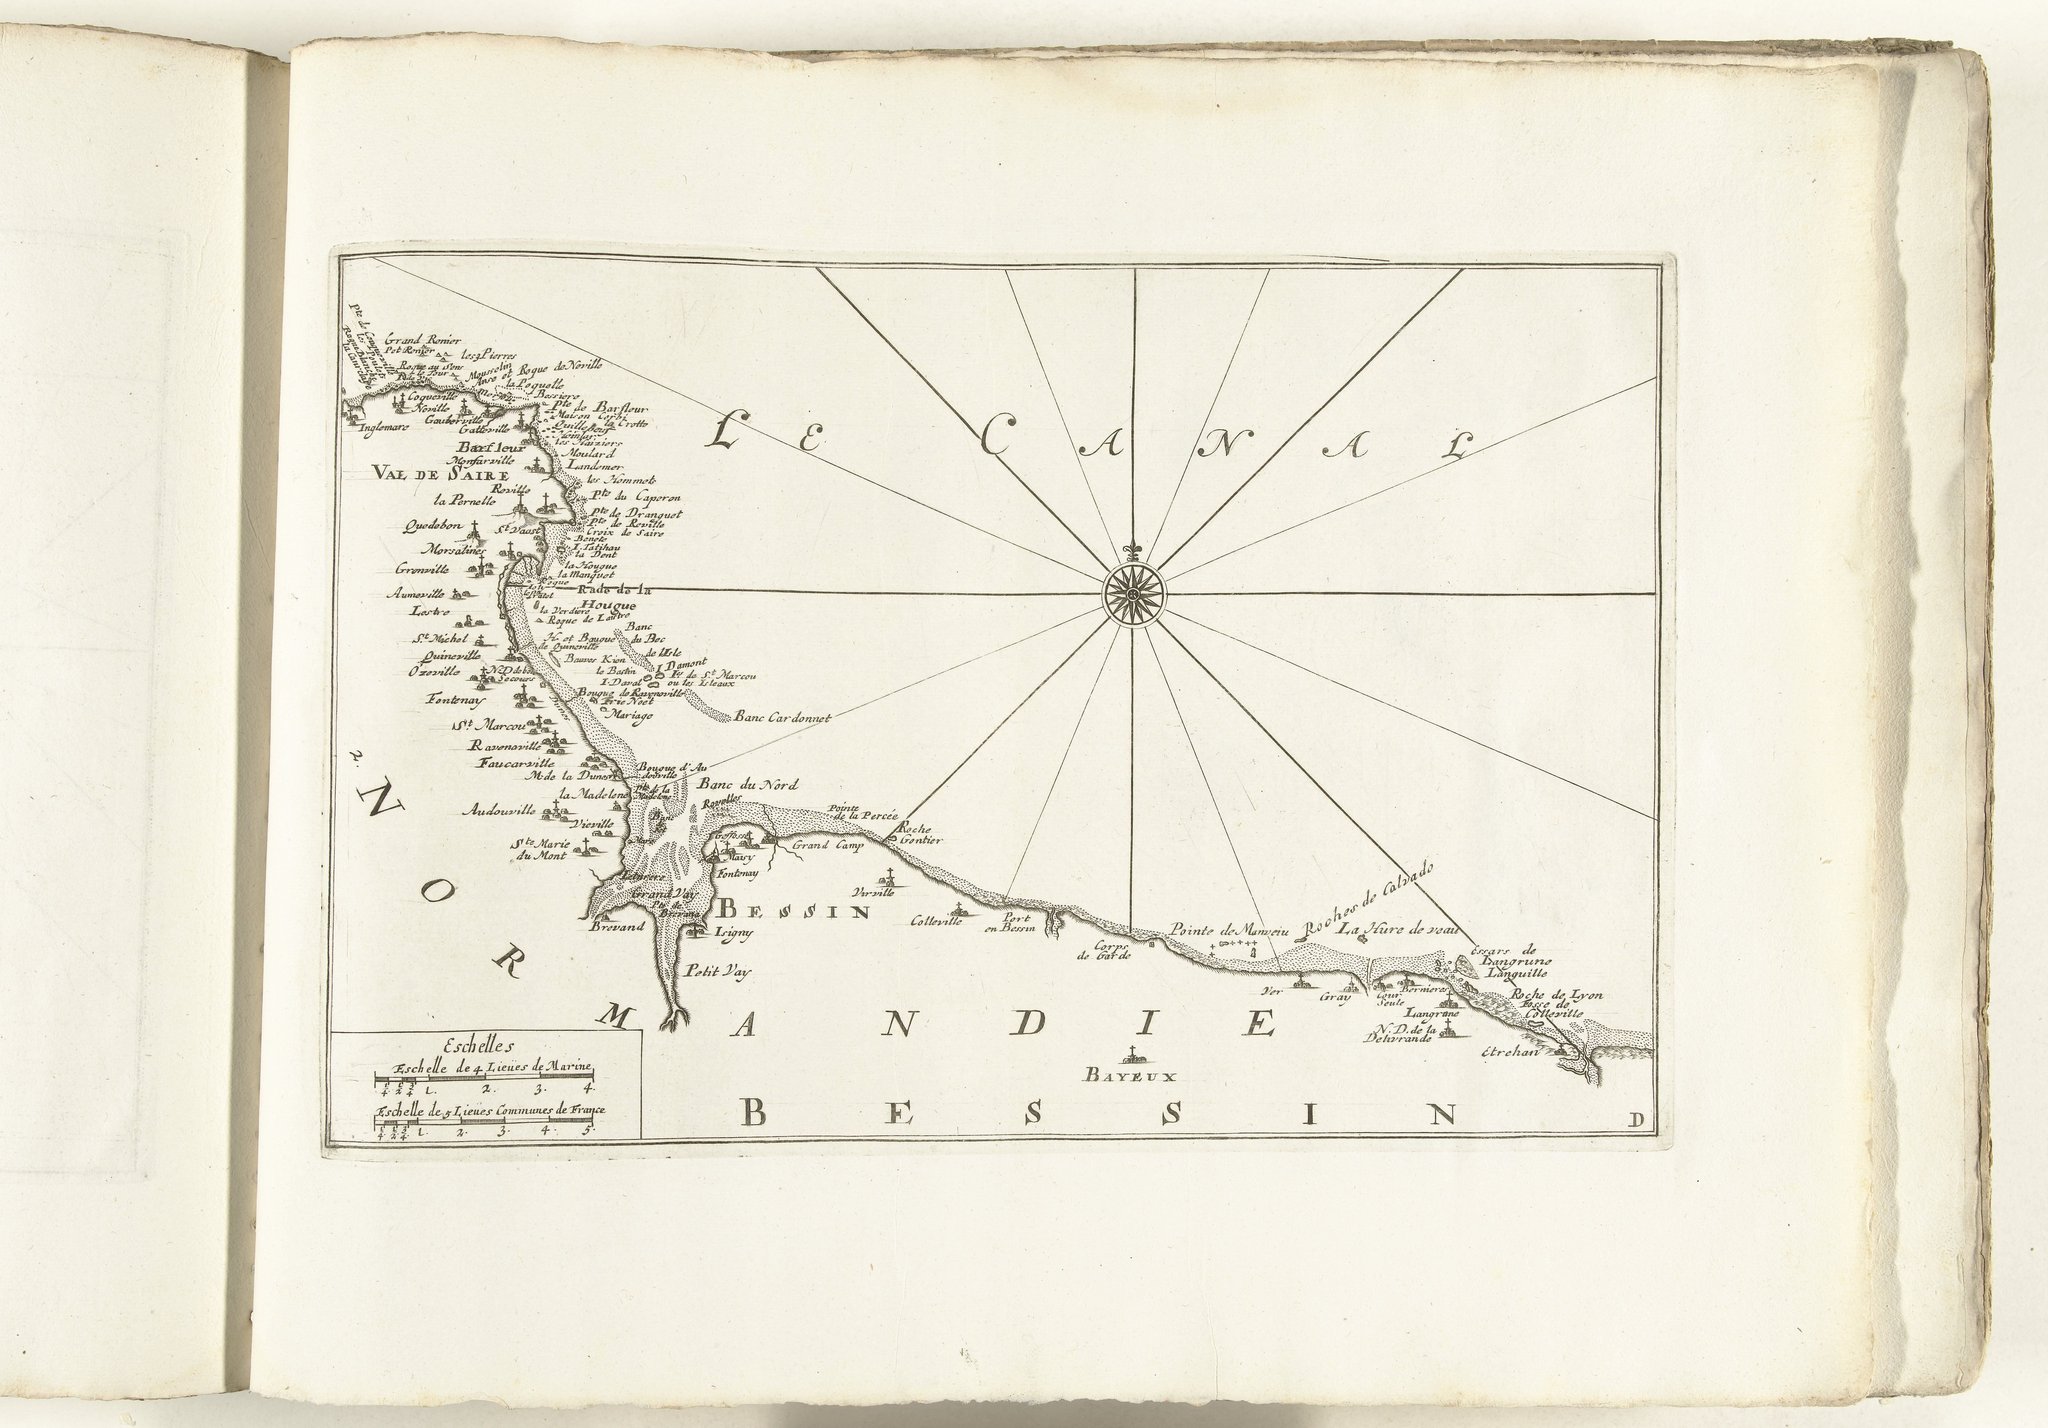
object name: print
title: Kaart van de Franse kust tussen Barfleur en Bayeux, ca. 1702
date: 1702-1703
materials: paper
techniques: engraving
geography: amsterdam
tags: maps of separate countries or regions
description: Kaart van de Franse kust tussen Barfleur en Bayeux. Gemerkt rechtsonder: D. Onderdeel van het eerste van twee delen van het prentwerk: Les costes de France et d'Espagne (oftewel deel 13 van: Les Forces de l'Europe, Asie, Afrique et Amerique), uitgegeven ca. 1702. Het prentwerk bestaat in totaal uit 43 gemerkte platen van de kust van Frankrijk en Spanje, in het kader van de Spaanse Successieoorlog. Deze platen zijn gekopieerd naar anonieme Franse platen oorspronkelijk uitgegeven door Nicolas de Fer te Parijs. Titel en opschriften in de plaat in het Frans.